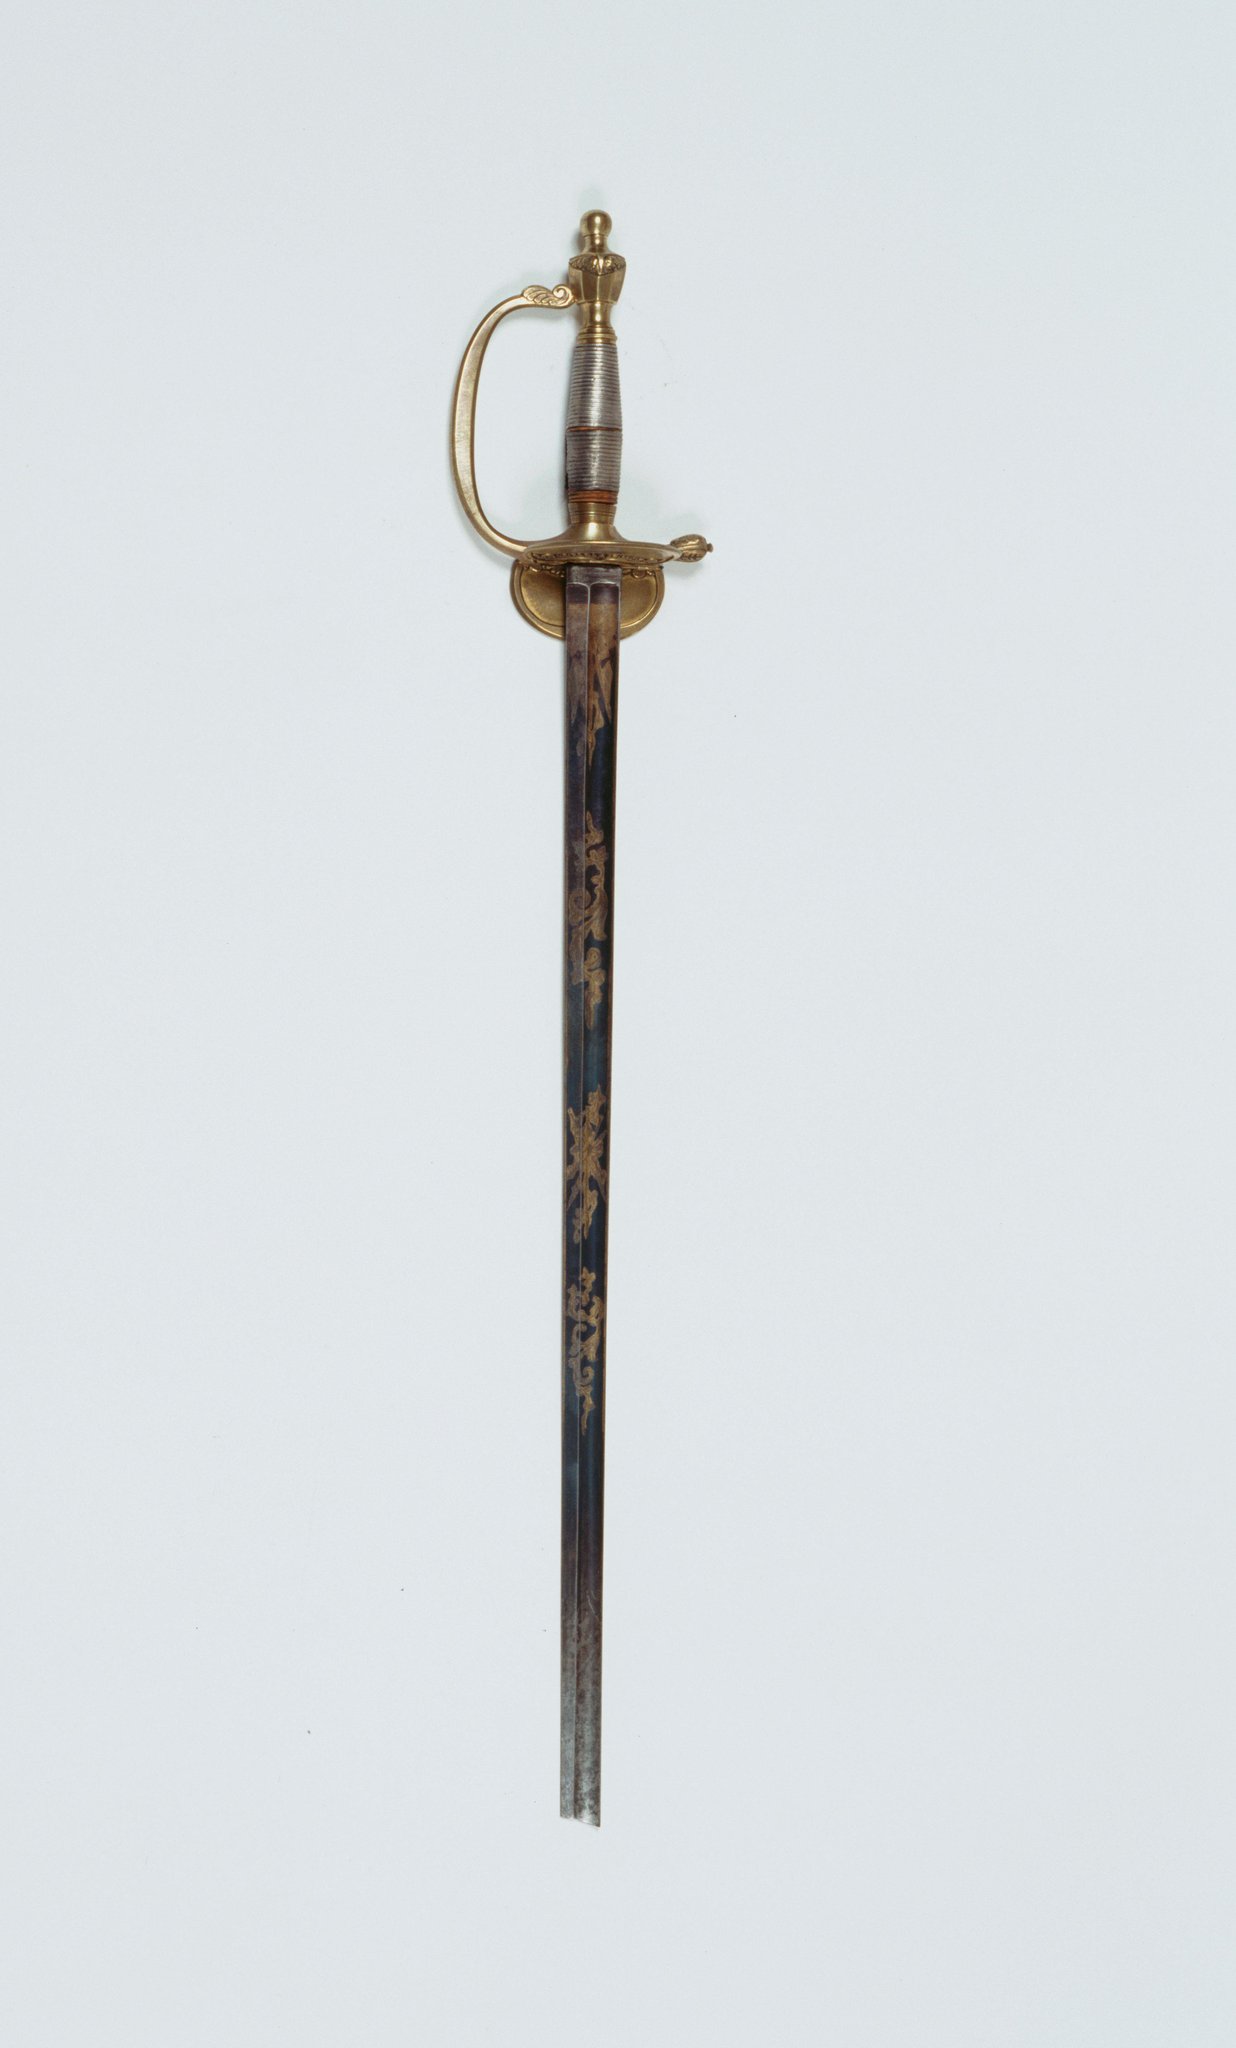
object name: sword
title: Officiersdegen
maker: Anonymous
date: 1400-1950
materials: copper, iron, silver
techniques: burnishing, gilding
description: Degen met koperen gevest, beweegbare stootplaat en zilveren greep. Het lemmet is gebruineerd met vergulde ornamenten, op een zijde onleesbaar opschrift, op andere zijde: a Amsterdam. Met schede. Afkomstig Baron J.W.C. van Ittersum, 2e Bataljon Jagers. Degen is gebroken en schede ontbreekt.